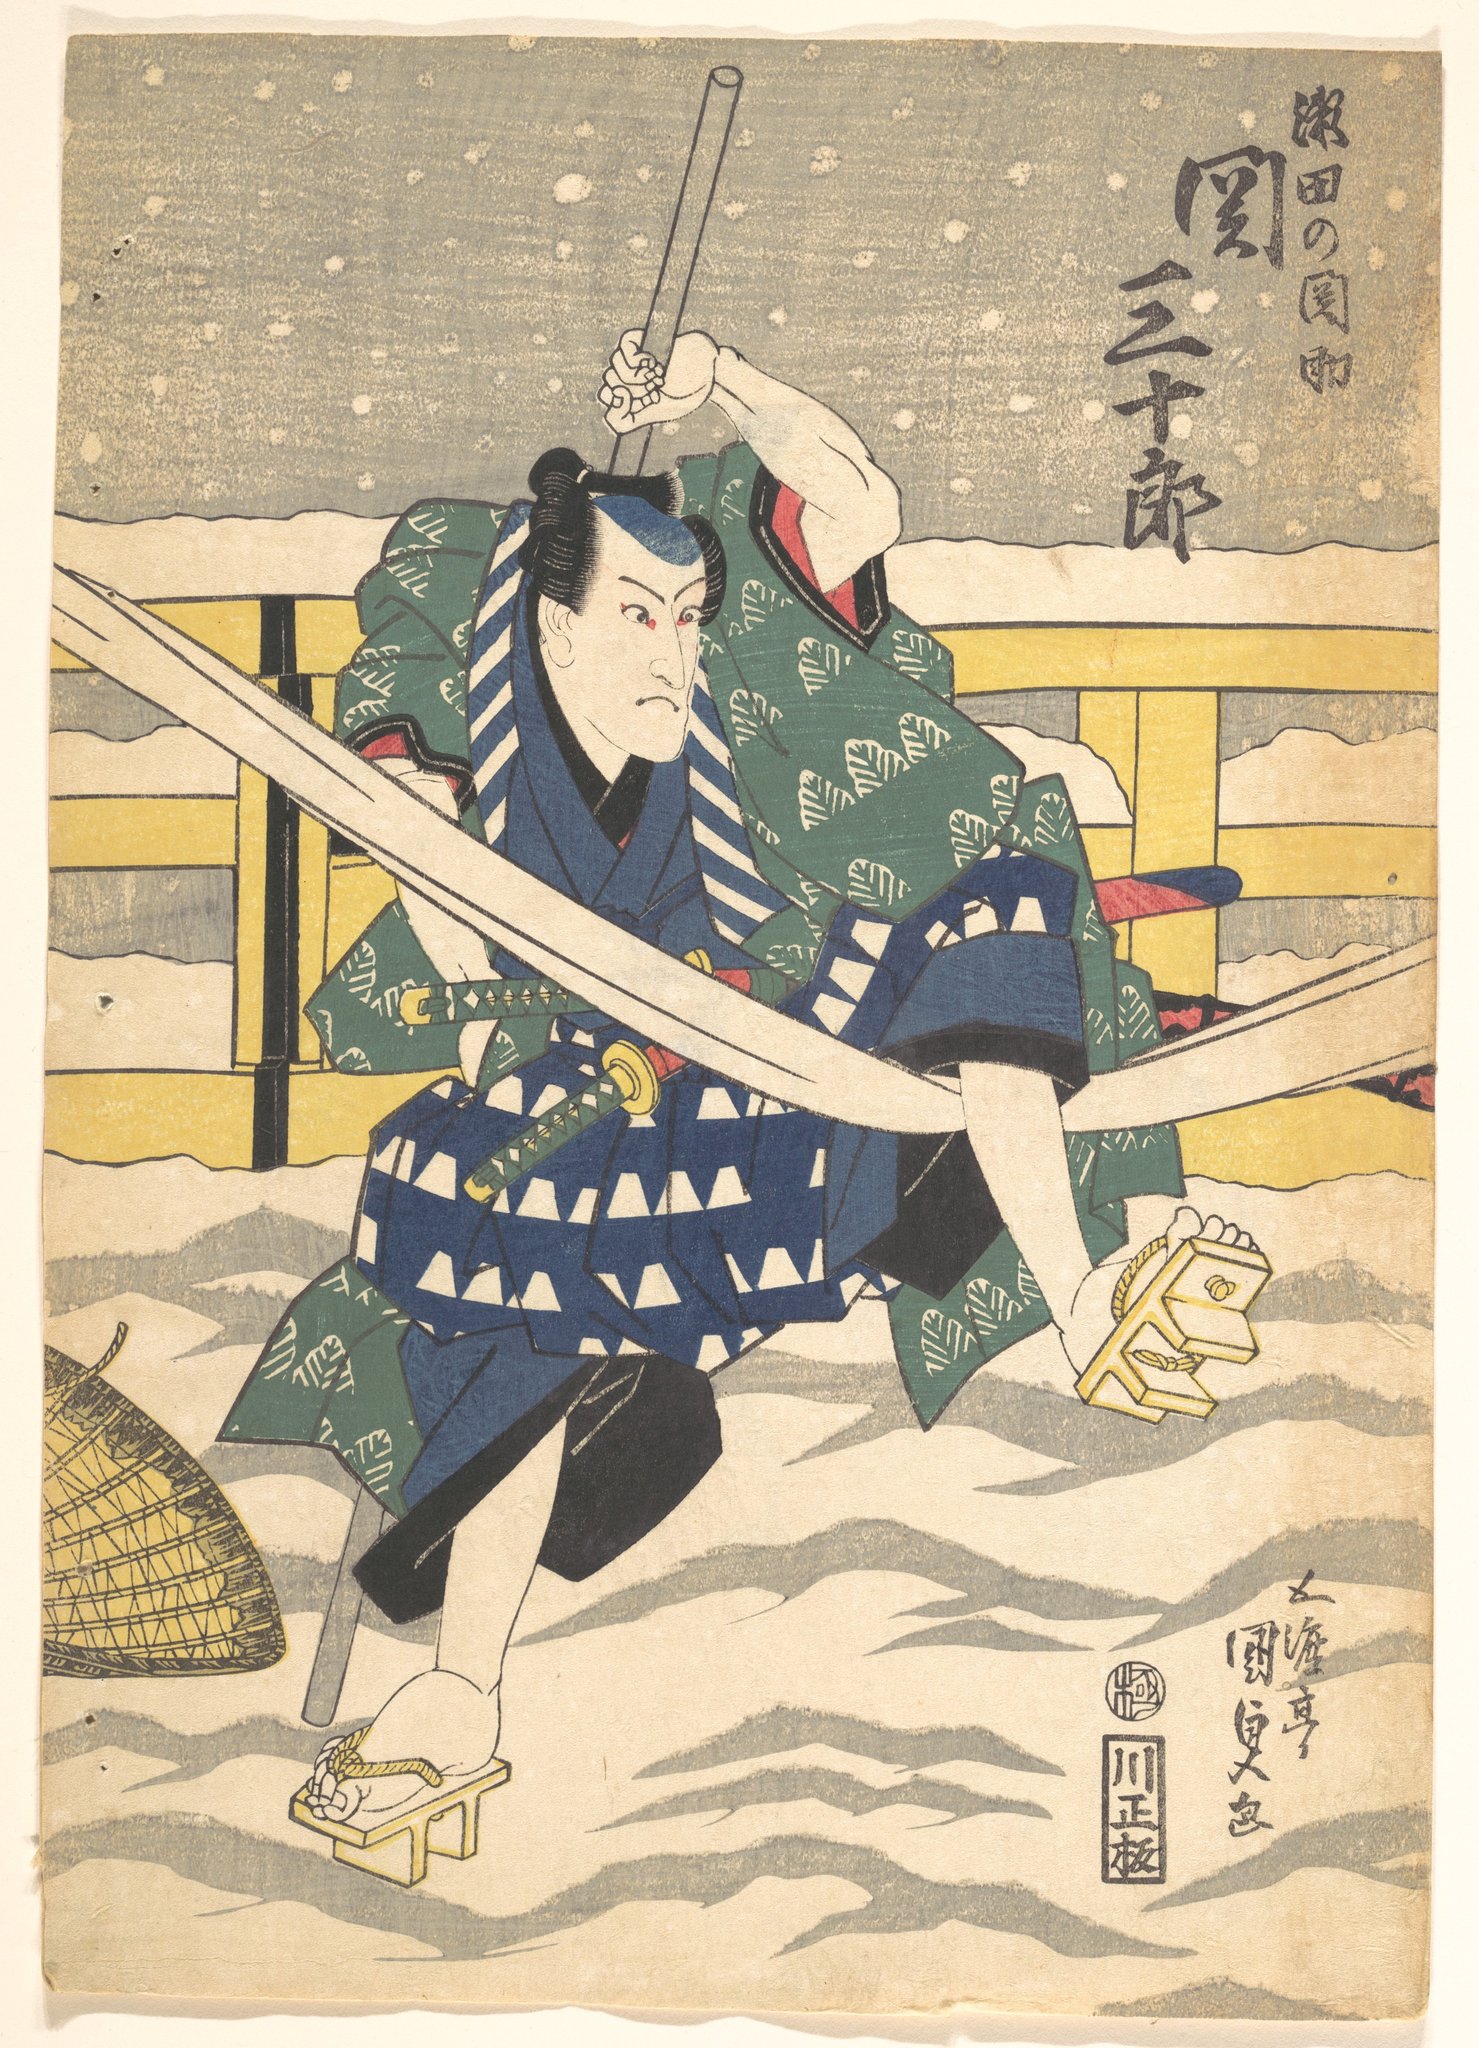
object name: print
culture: japanese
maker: utagawa kunisada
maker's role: artist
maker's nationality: japanese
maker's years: 1786-1864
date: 1801-1900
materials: ink, paper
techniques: woodblock print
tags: men